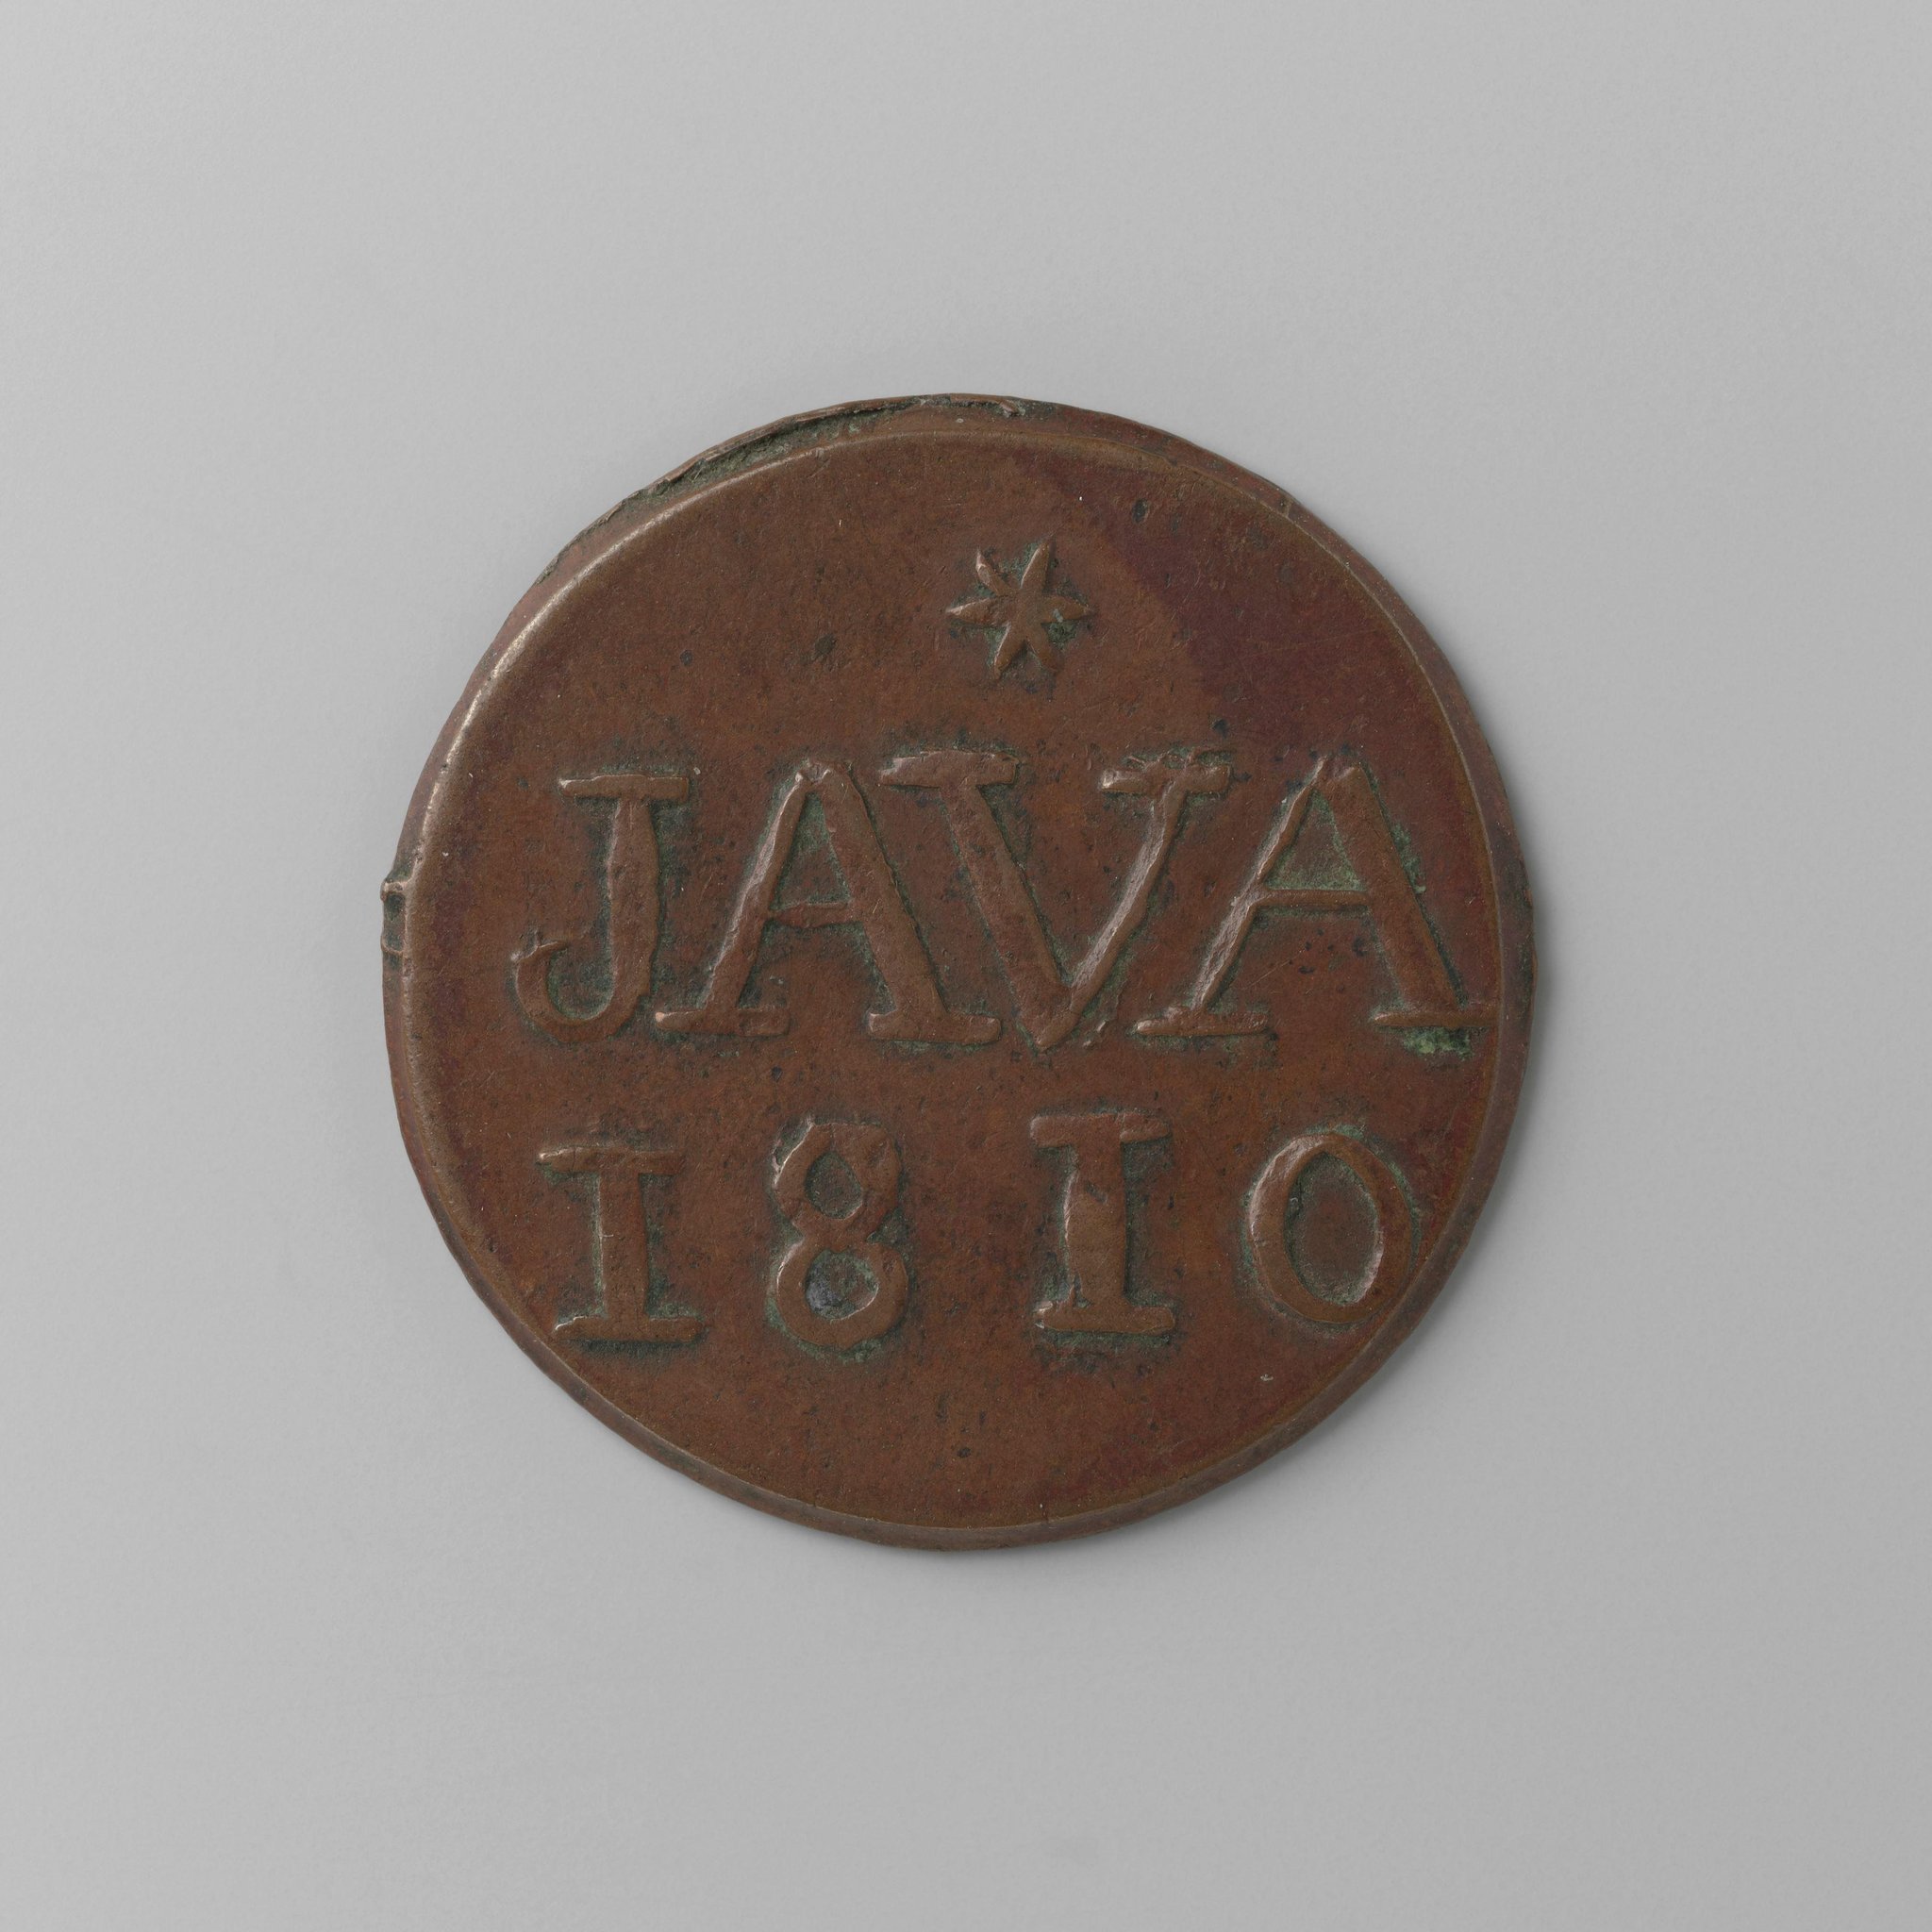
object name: coin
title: Nederlands Indië, duit Java, 1810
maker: louis napoleon (king of holland)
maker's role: koning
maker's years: 1778-1846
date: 1810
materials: copper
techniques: striking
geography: surabaya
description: Koperen munt. Voorzijde: initialen L en N van Lodewijk Napoleon. Daarboven muntteken. Keerzijde: eenregelig opschrift, waaronder jaartal. Boven opschrift muntteken.